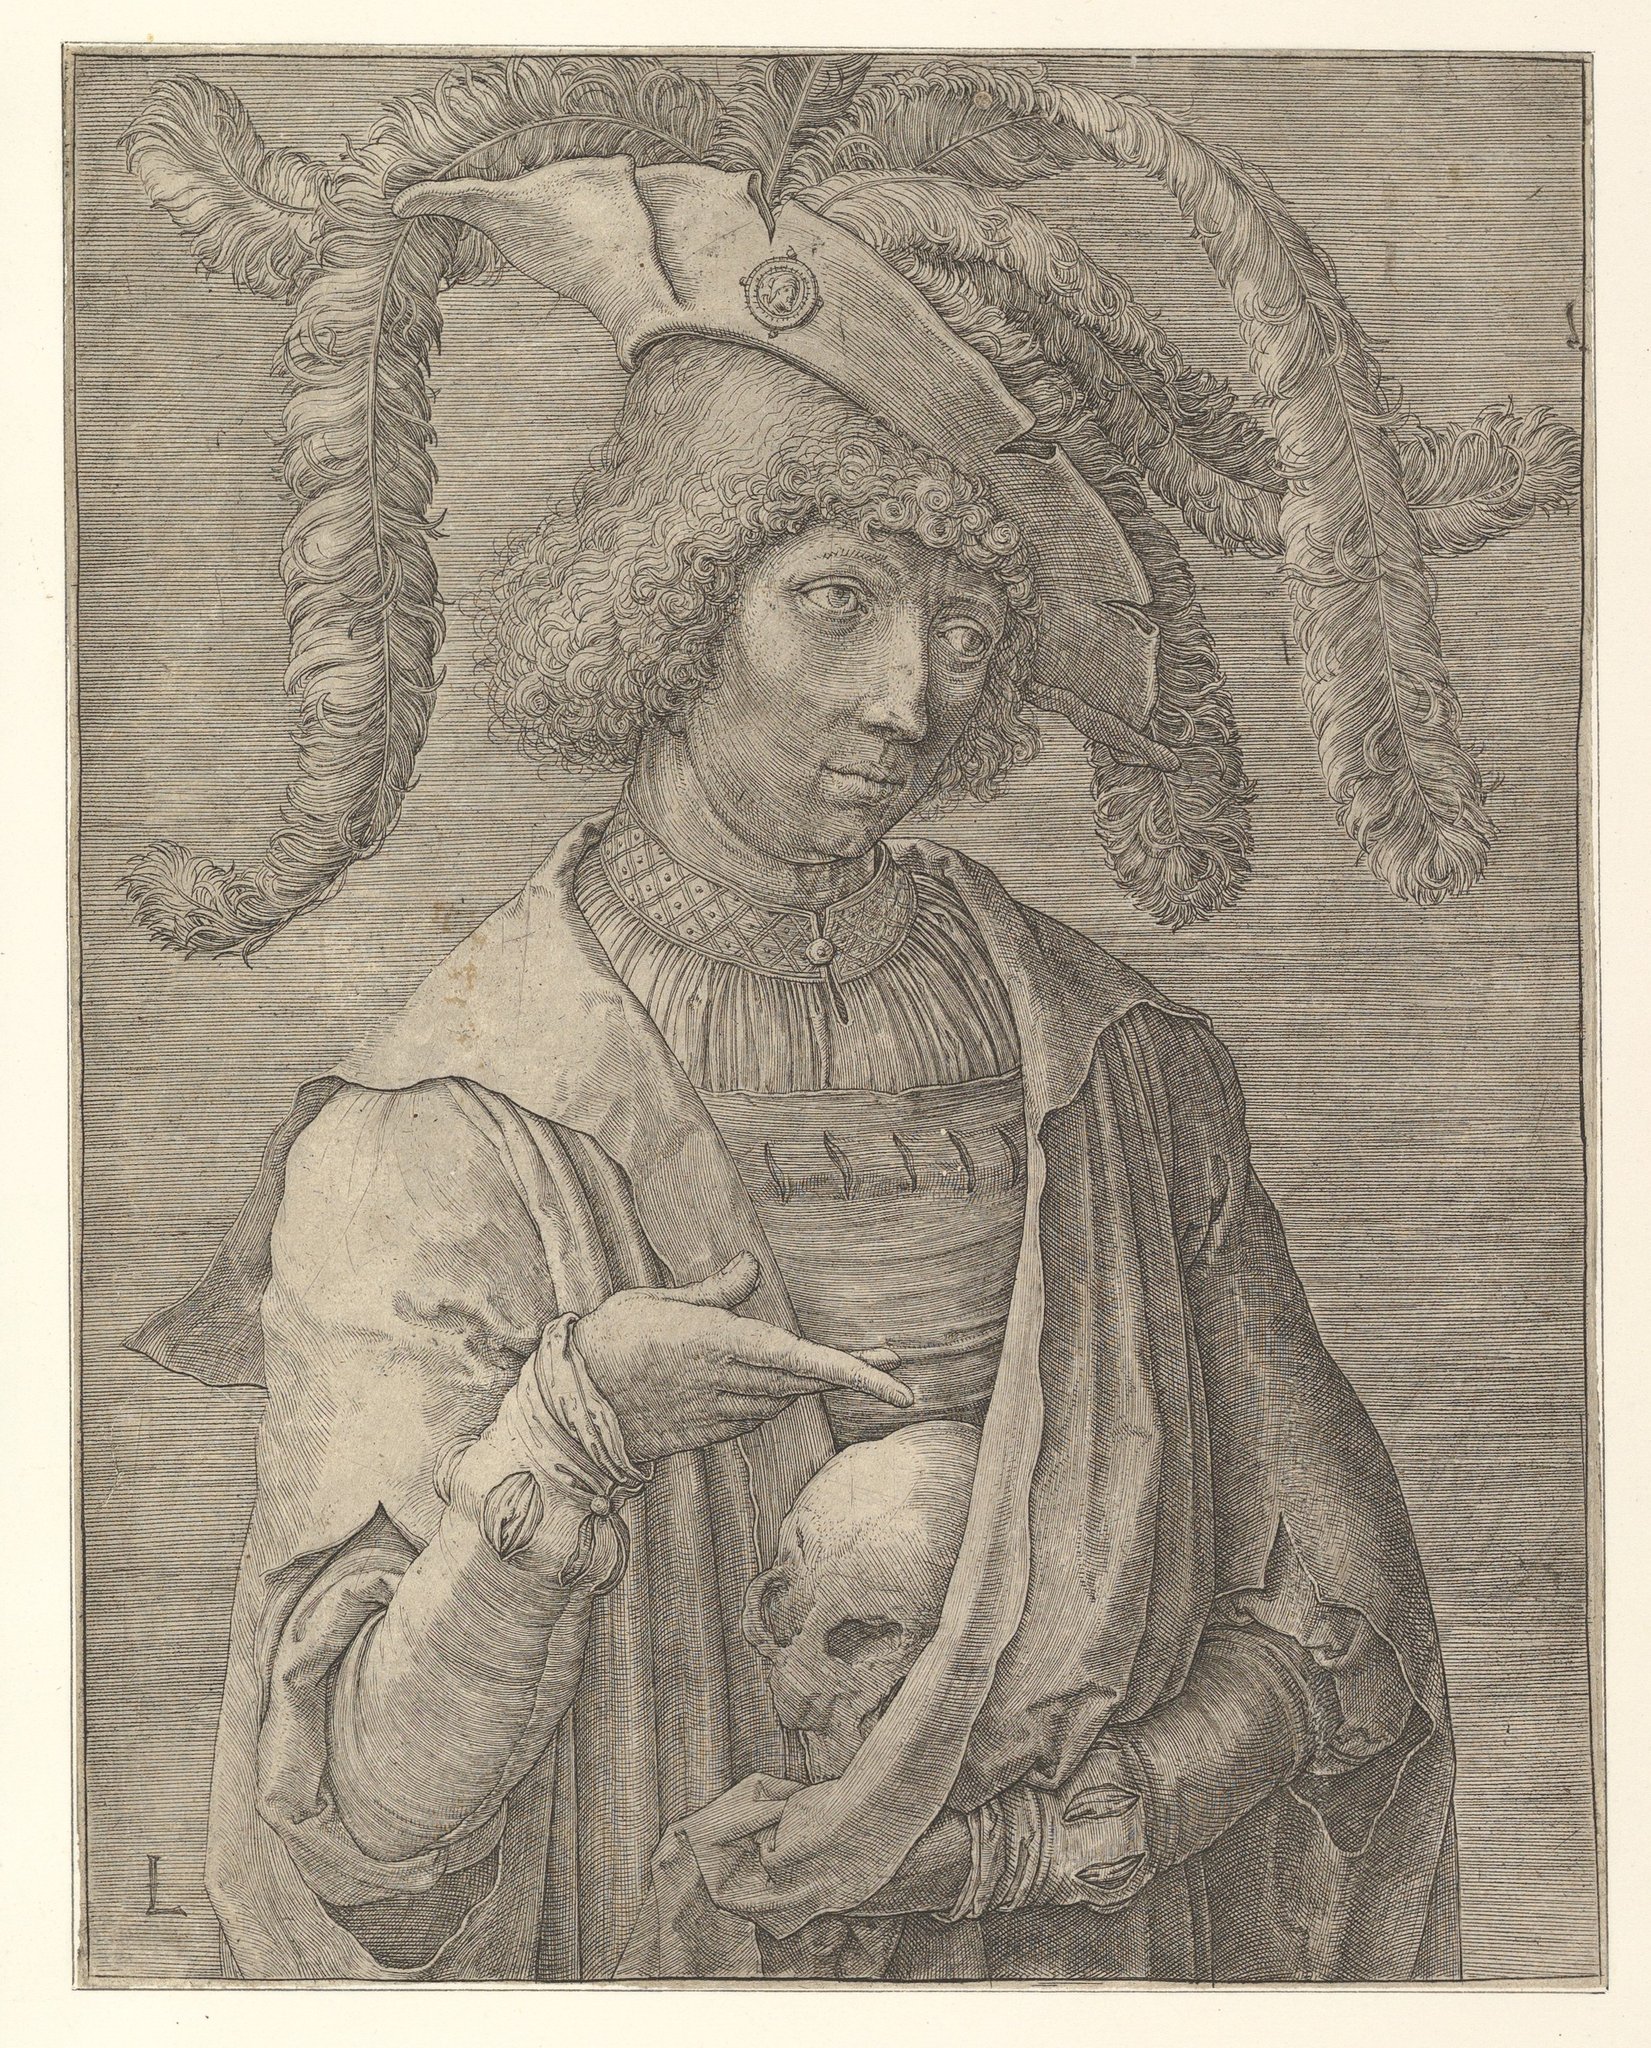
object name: print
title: Young Man with a Skull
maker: lucas van leyden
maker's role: artist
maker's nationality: netherlandish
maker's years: 1494-1533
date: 1519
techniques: engraving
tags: skulls,men,portraits